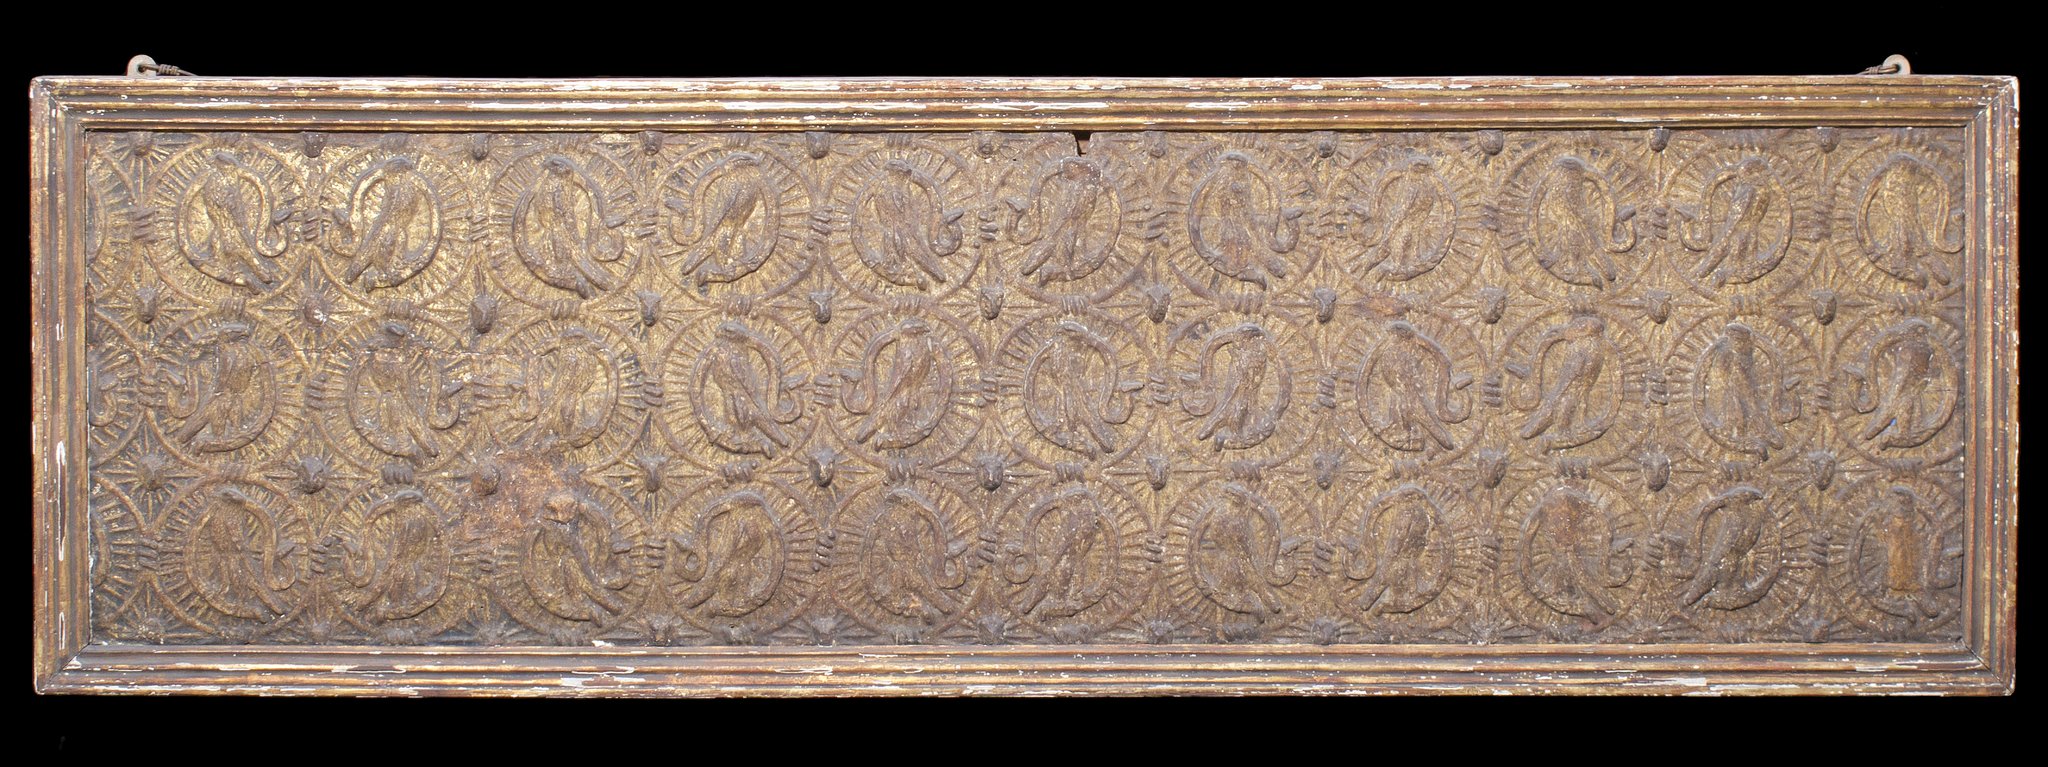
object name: cassone front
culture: italian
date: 1367-1400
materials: gesso, paint, wood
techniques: gilding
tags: eagles